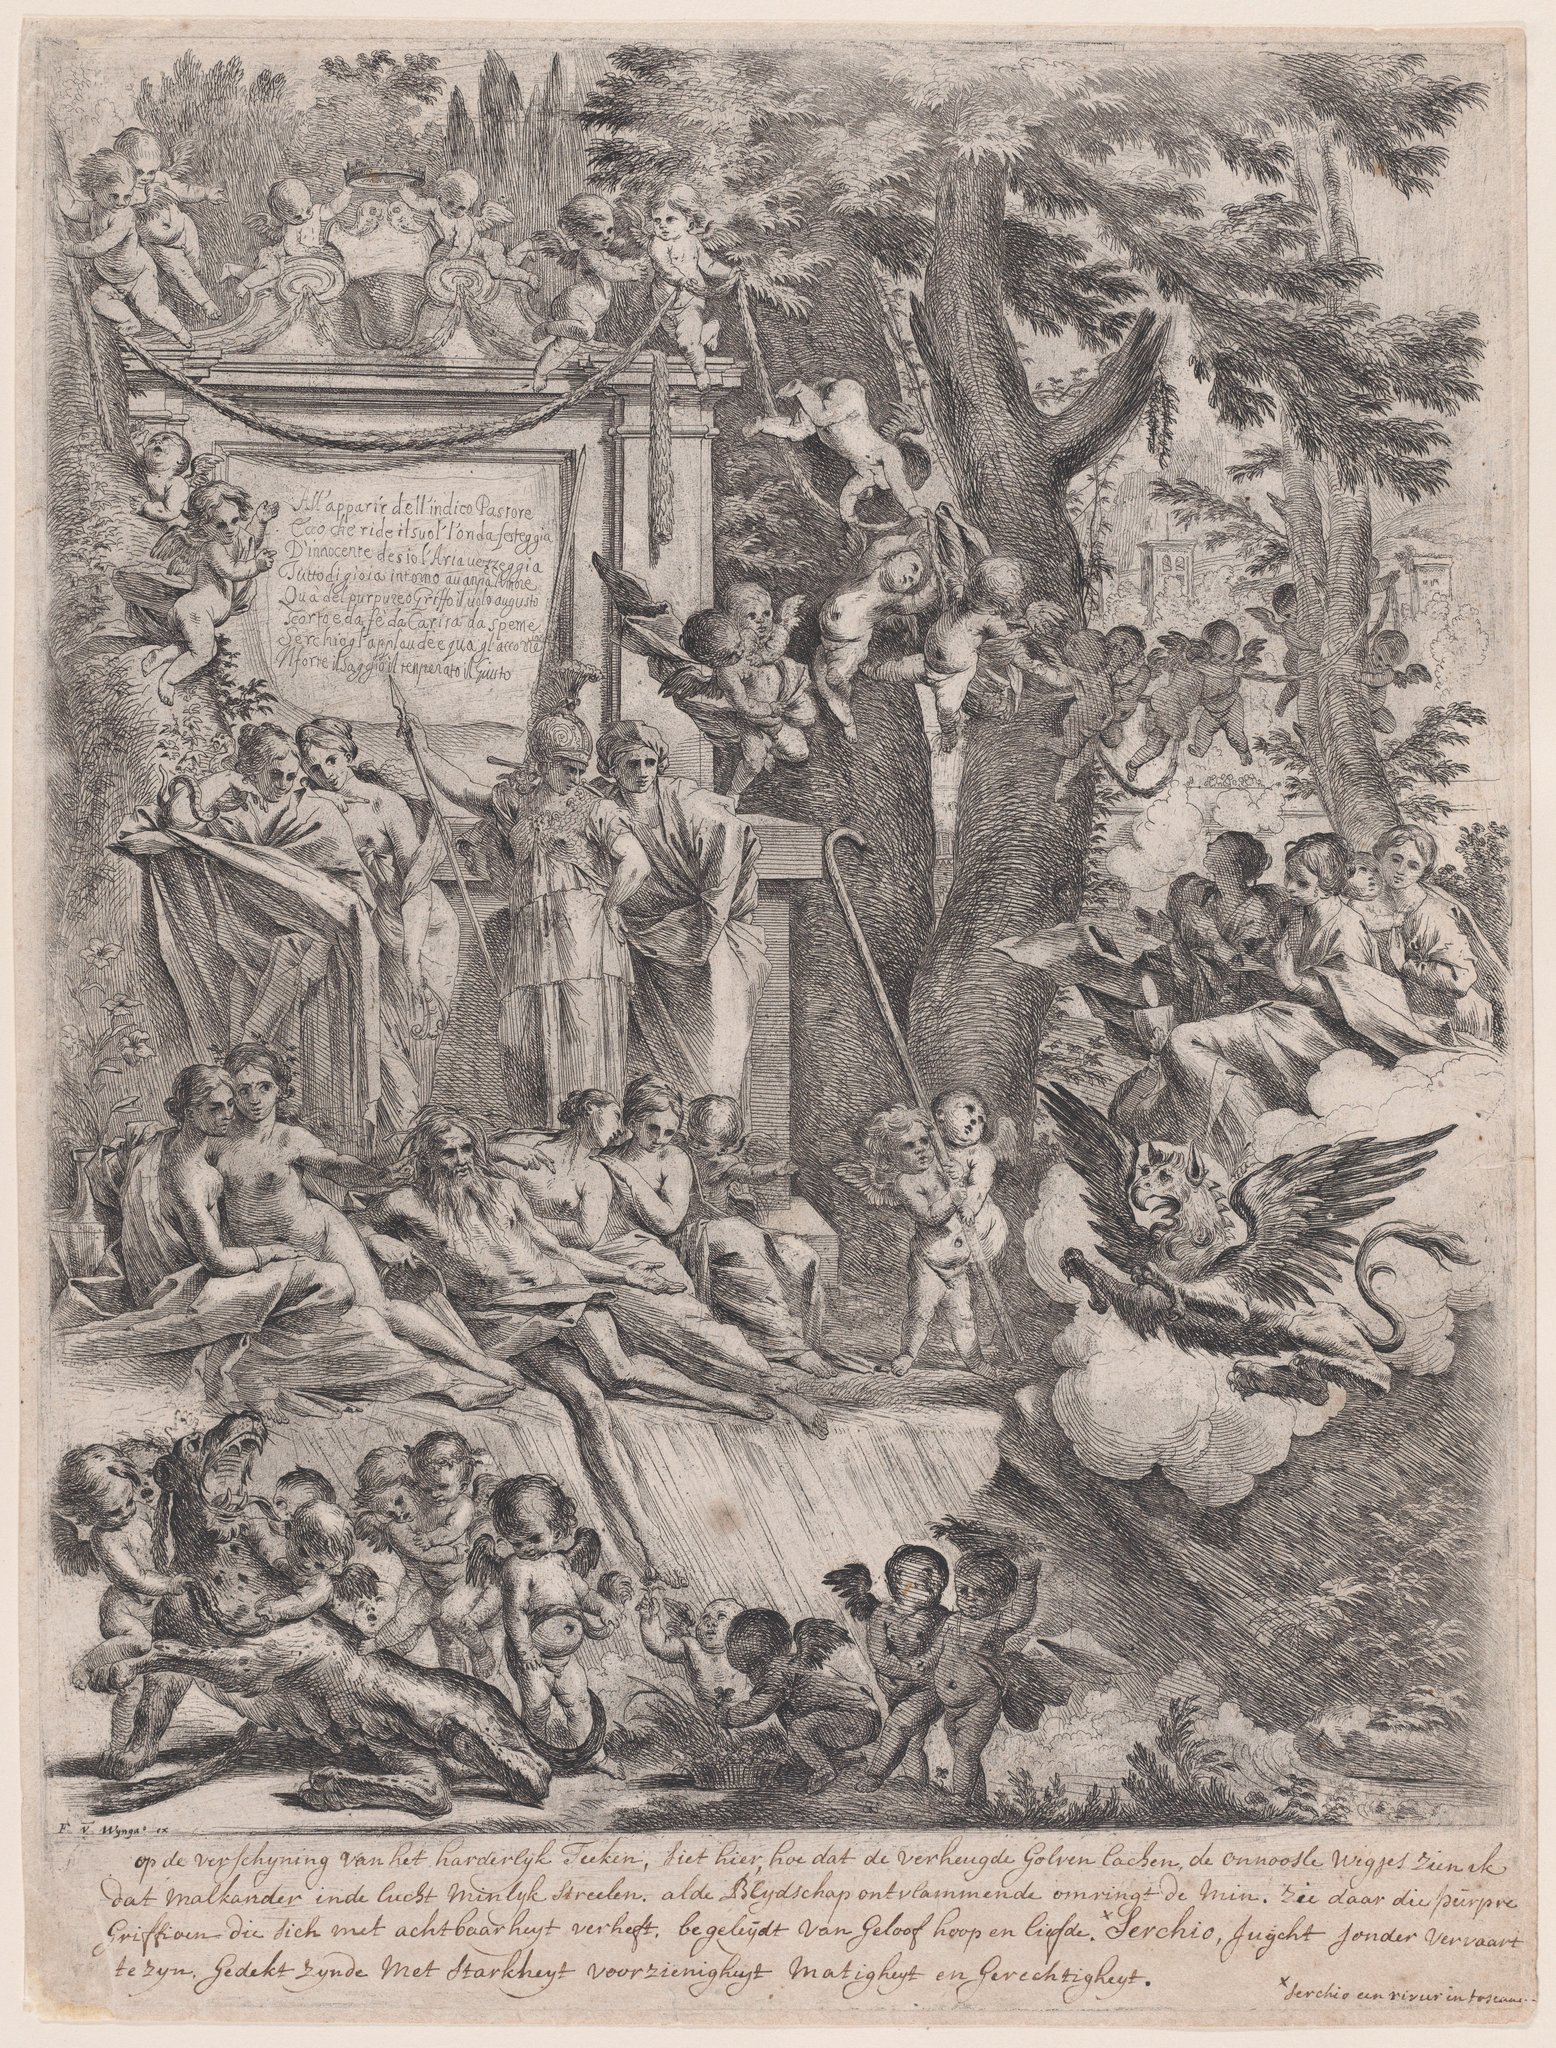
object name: print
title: An allegory in honor of the arrival of Cardinal Franciotti as Bishop of Lucca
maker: pietro testa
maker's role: artist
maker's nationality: italian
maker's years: 1612-1650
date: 1637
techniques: etching